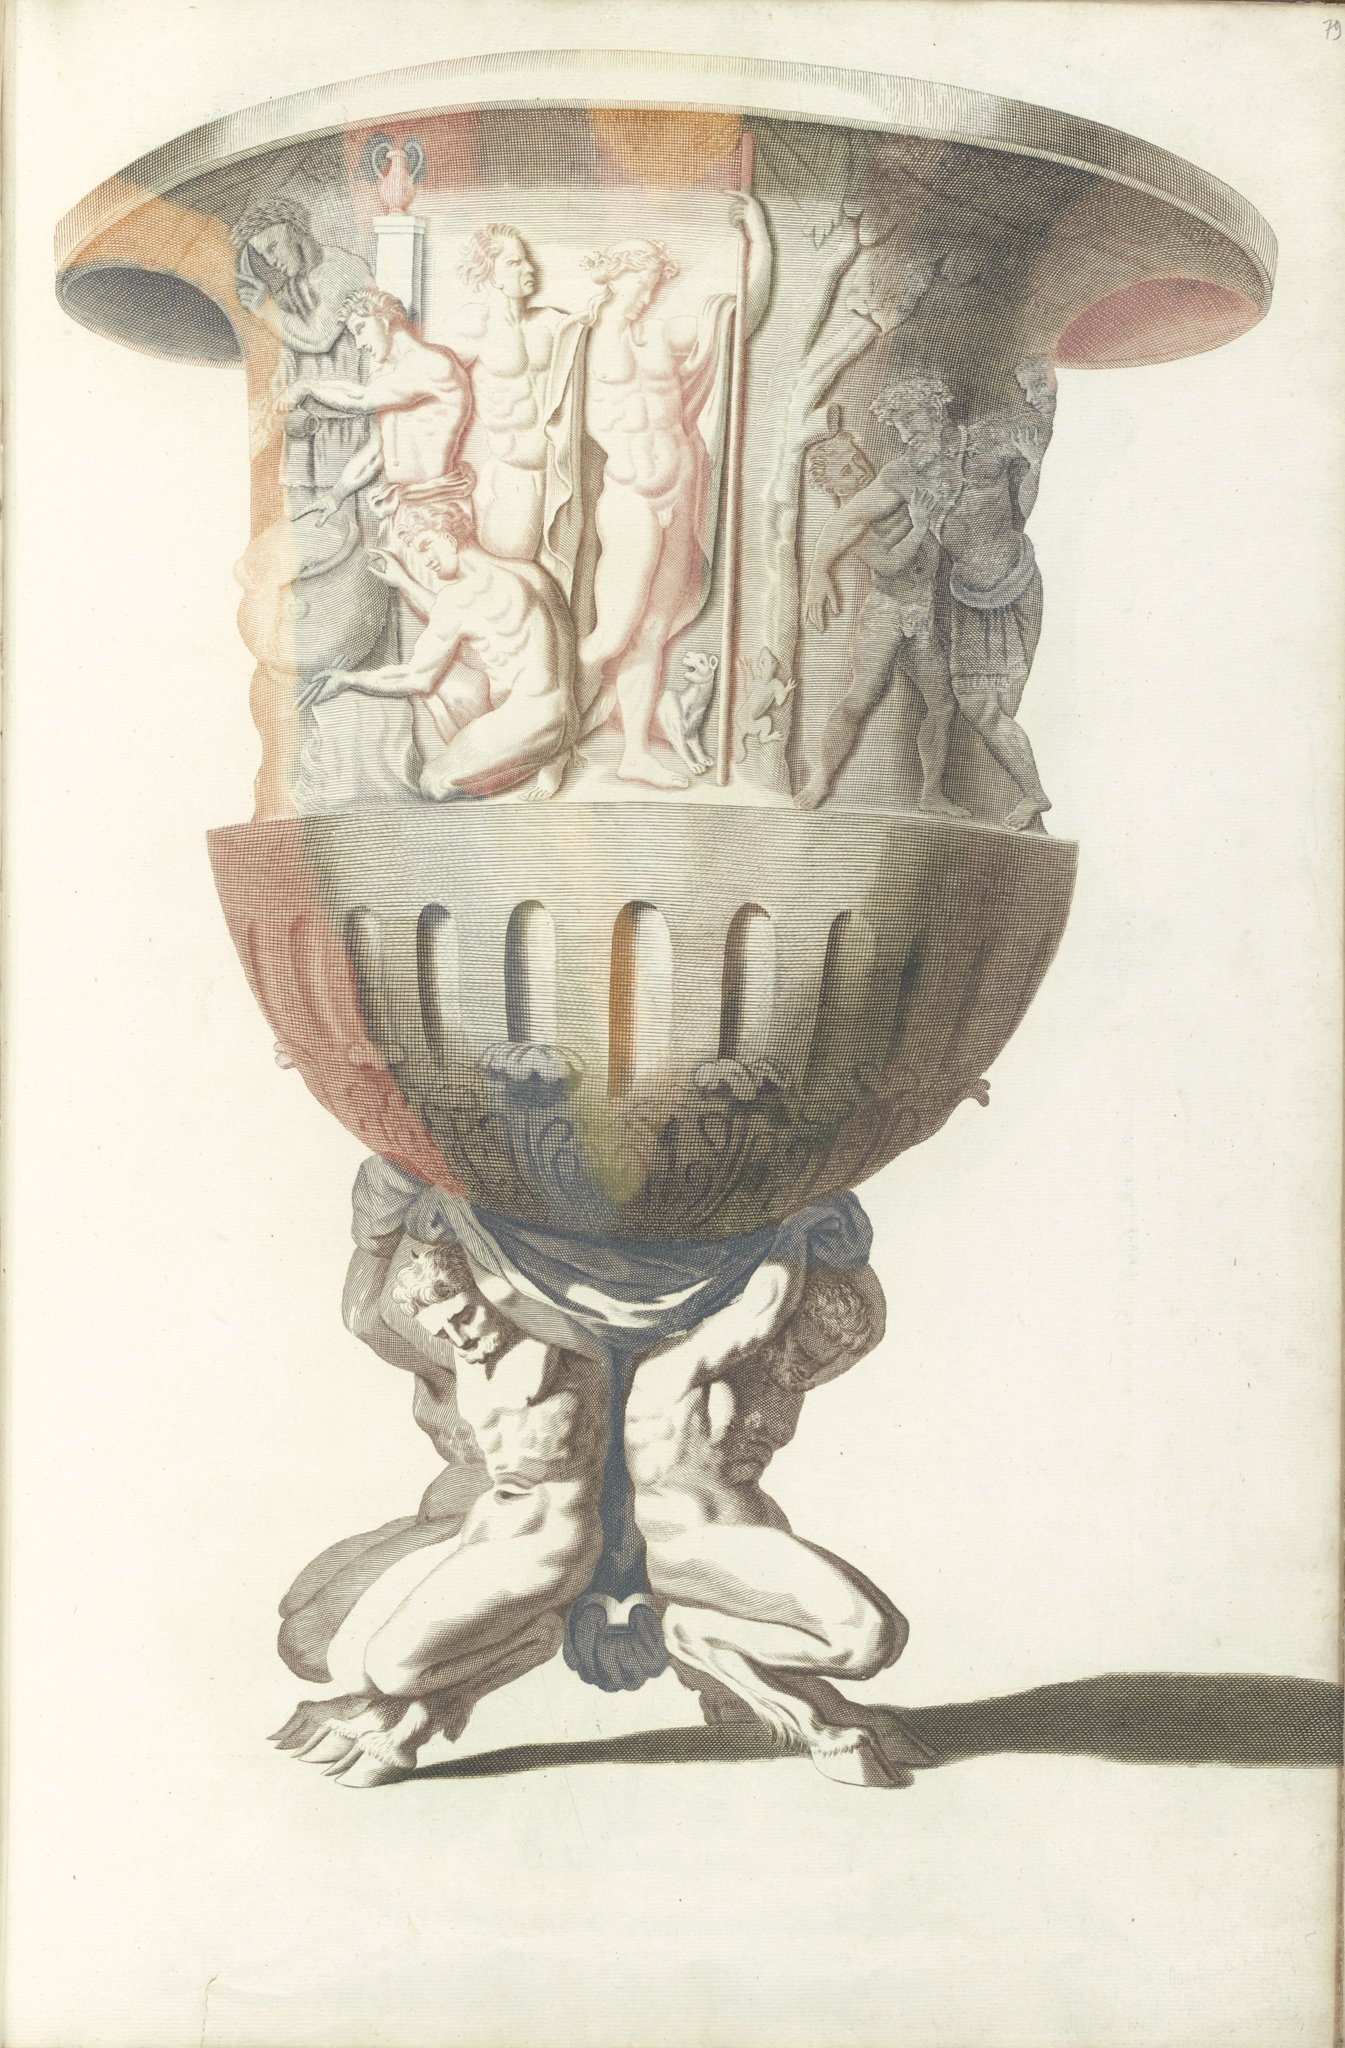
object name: print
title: Vaas gedragen door saters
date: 1688-1698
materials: paper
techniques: printing, engraving, lithography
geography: netherlands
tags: vase ~ ornament, satyr(s) (in general)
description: Een vaas met klassieke figuren, gedragen door saters. Deze prent maakt deel uit van een album.